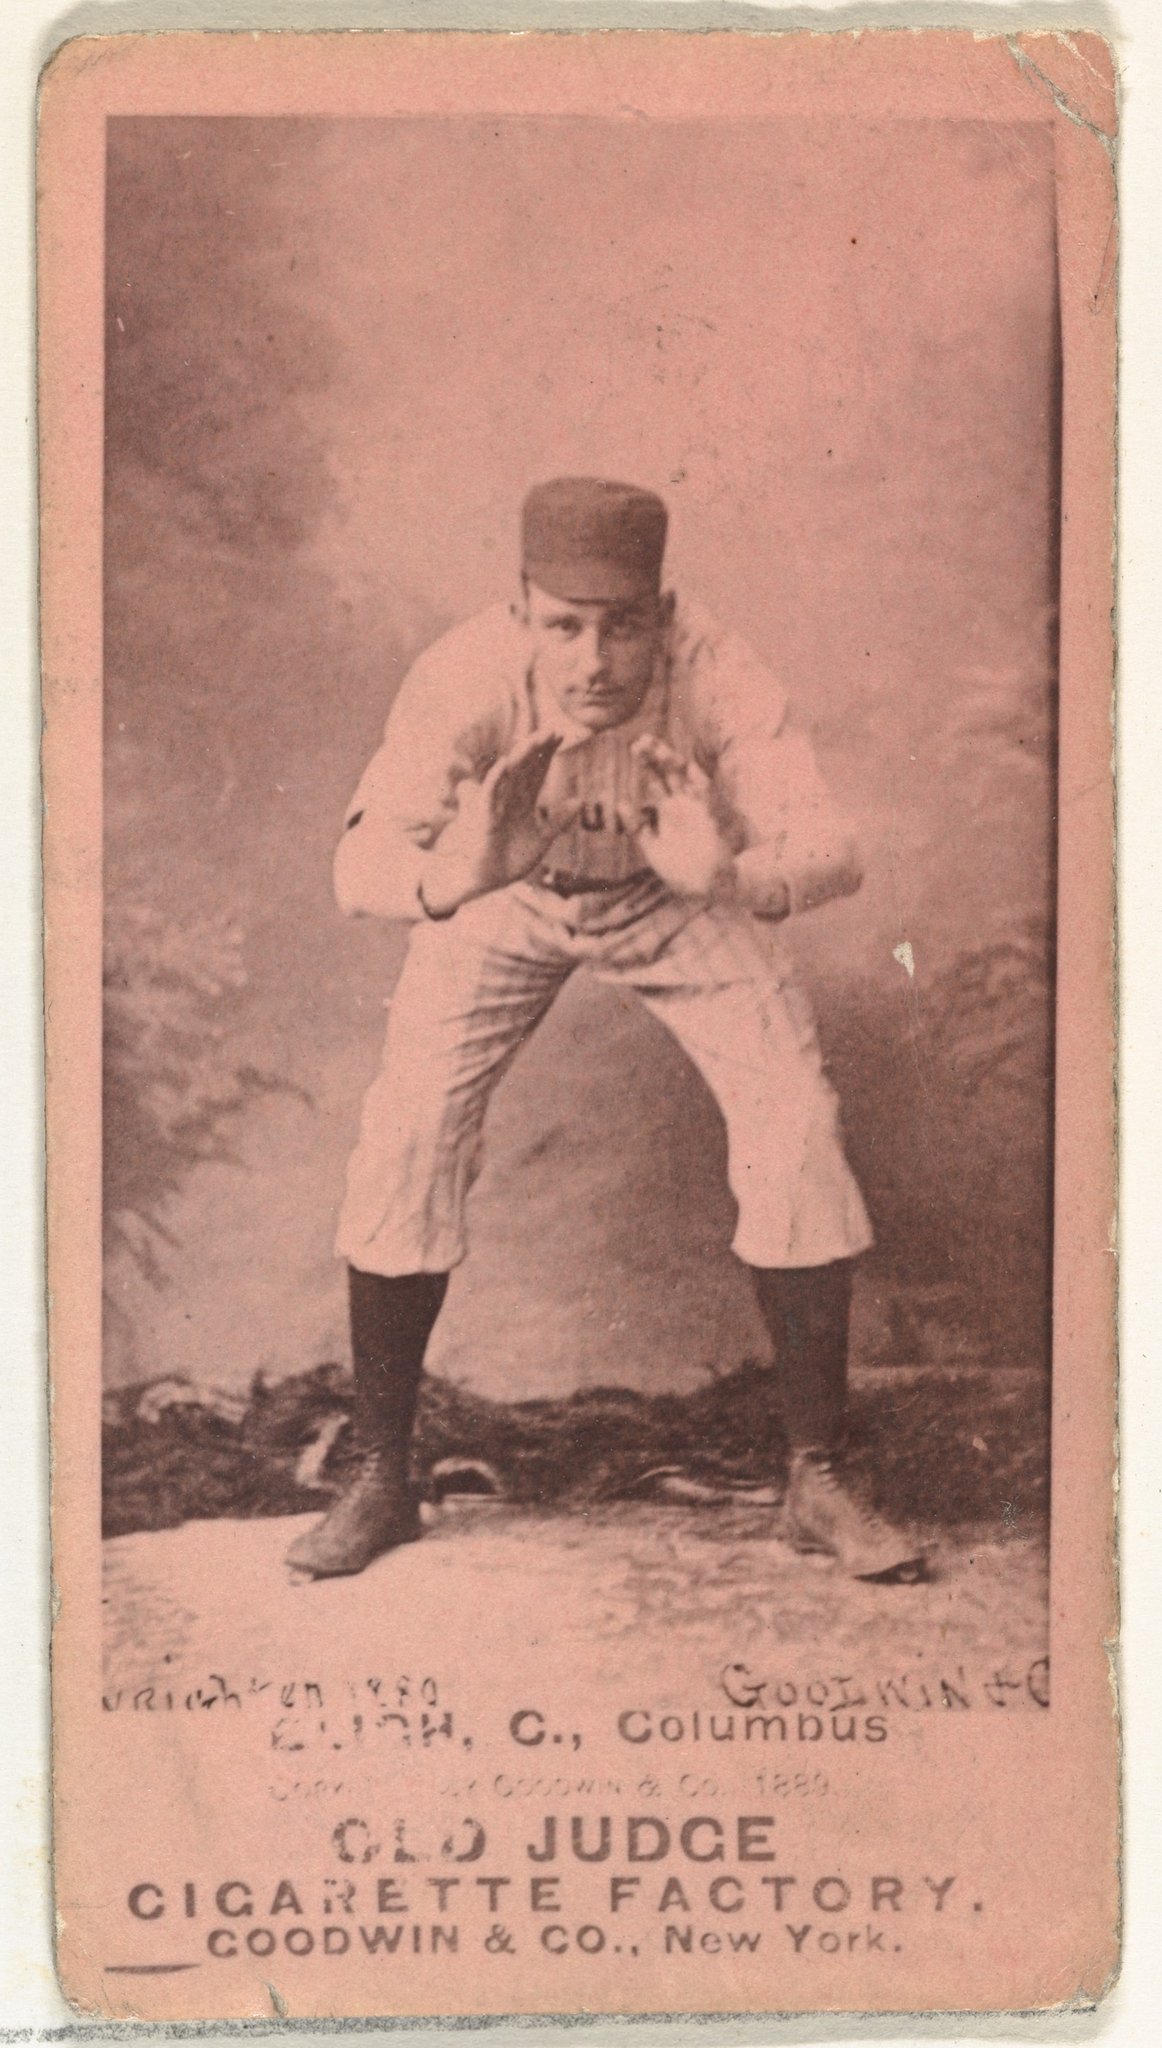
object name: baseball card, photograph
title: Edwin Forrest "Ned" Bligh, Catcher, Cleveland, from the Old Judge series (N172) for Old Judge Cigarettes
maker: goodwin & company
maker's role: publisher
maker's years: 1850-1950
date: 1889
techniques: albumen silver print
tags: men,portraits,baseball,athletes